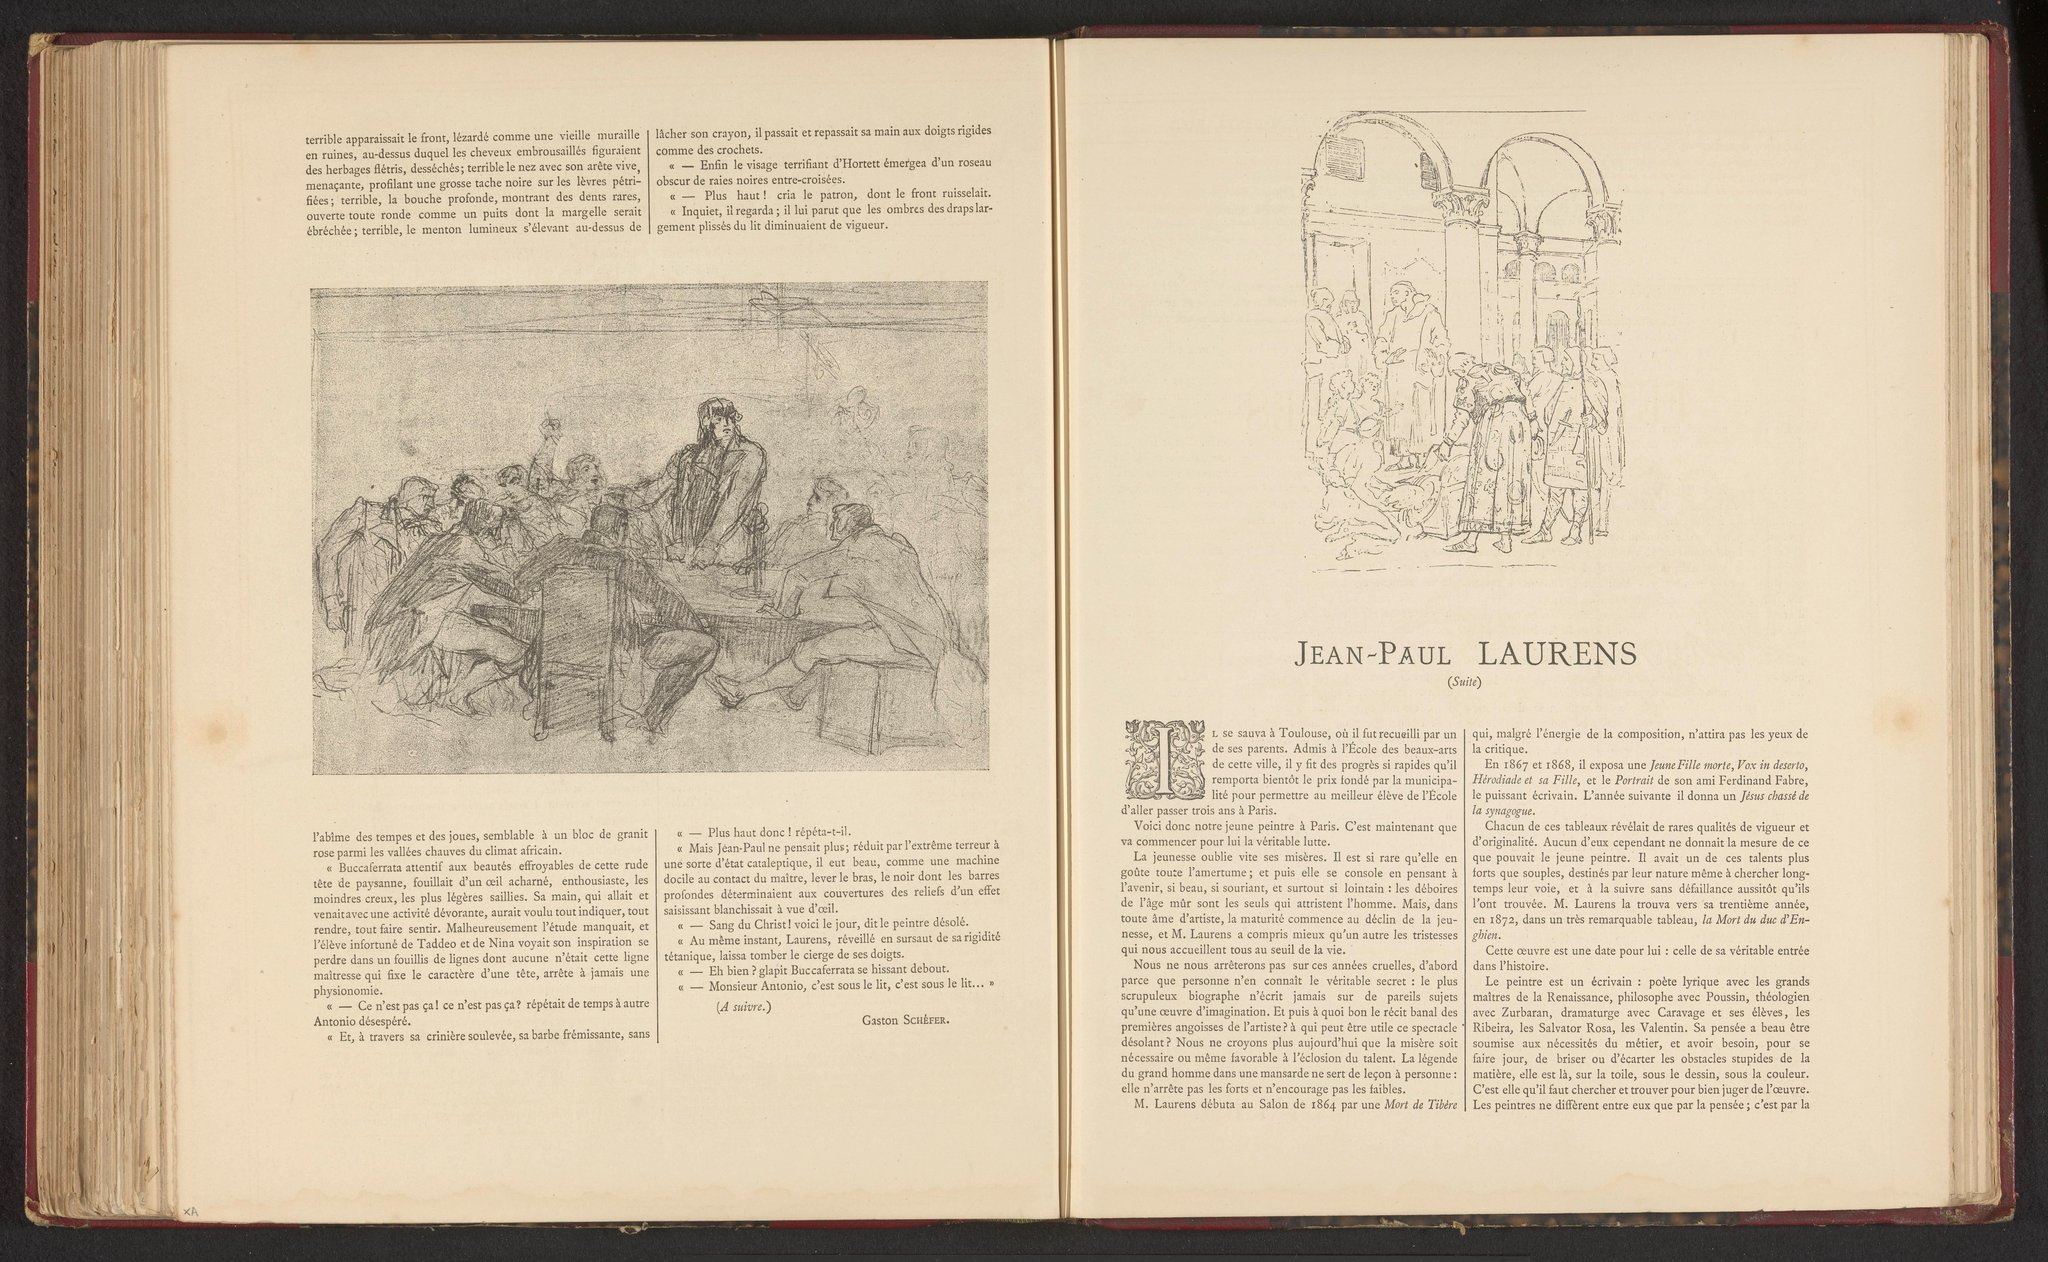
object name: photomechanical print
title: Fotoreproductie van een tekening door vermoedelijk Jean Paul Laurens, voorstellend een groep mannen rond een tafel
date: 1876-1879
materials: paper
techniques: autotype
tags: drawing, sketch